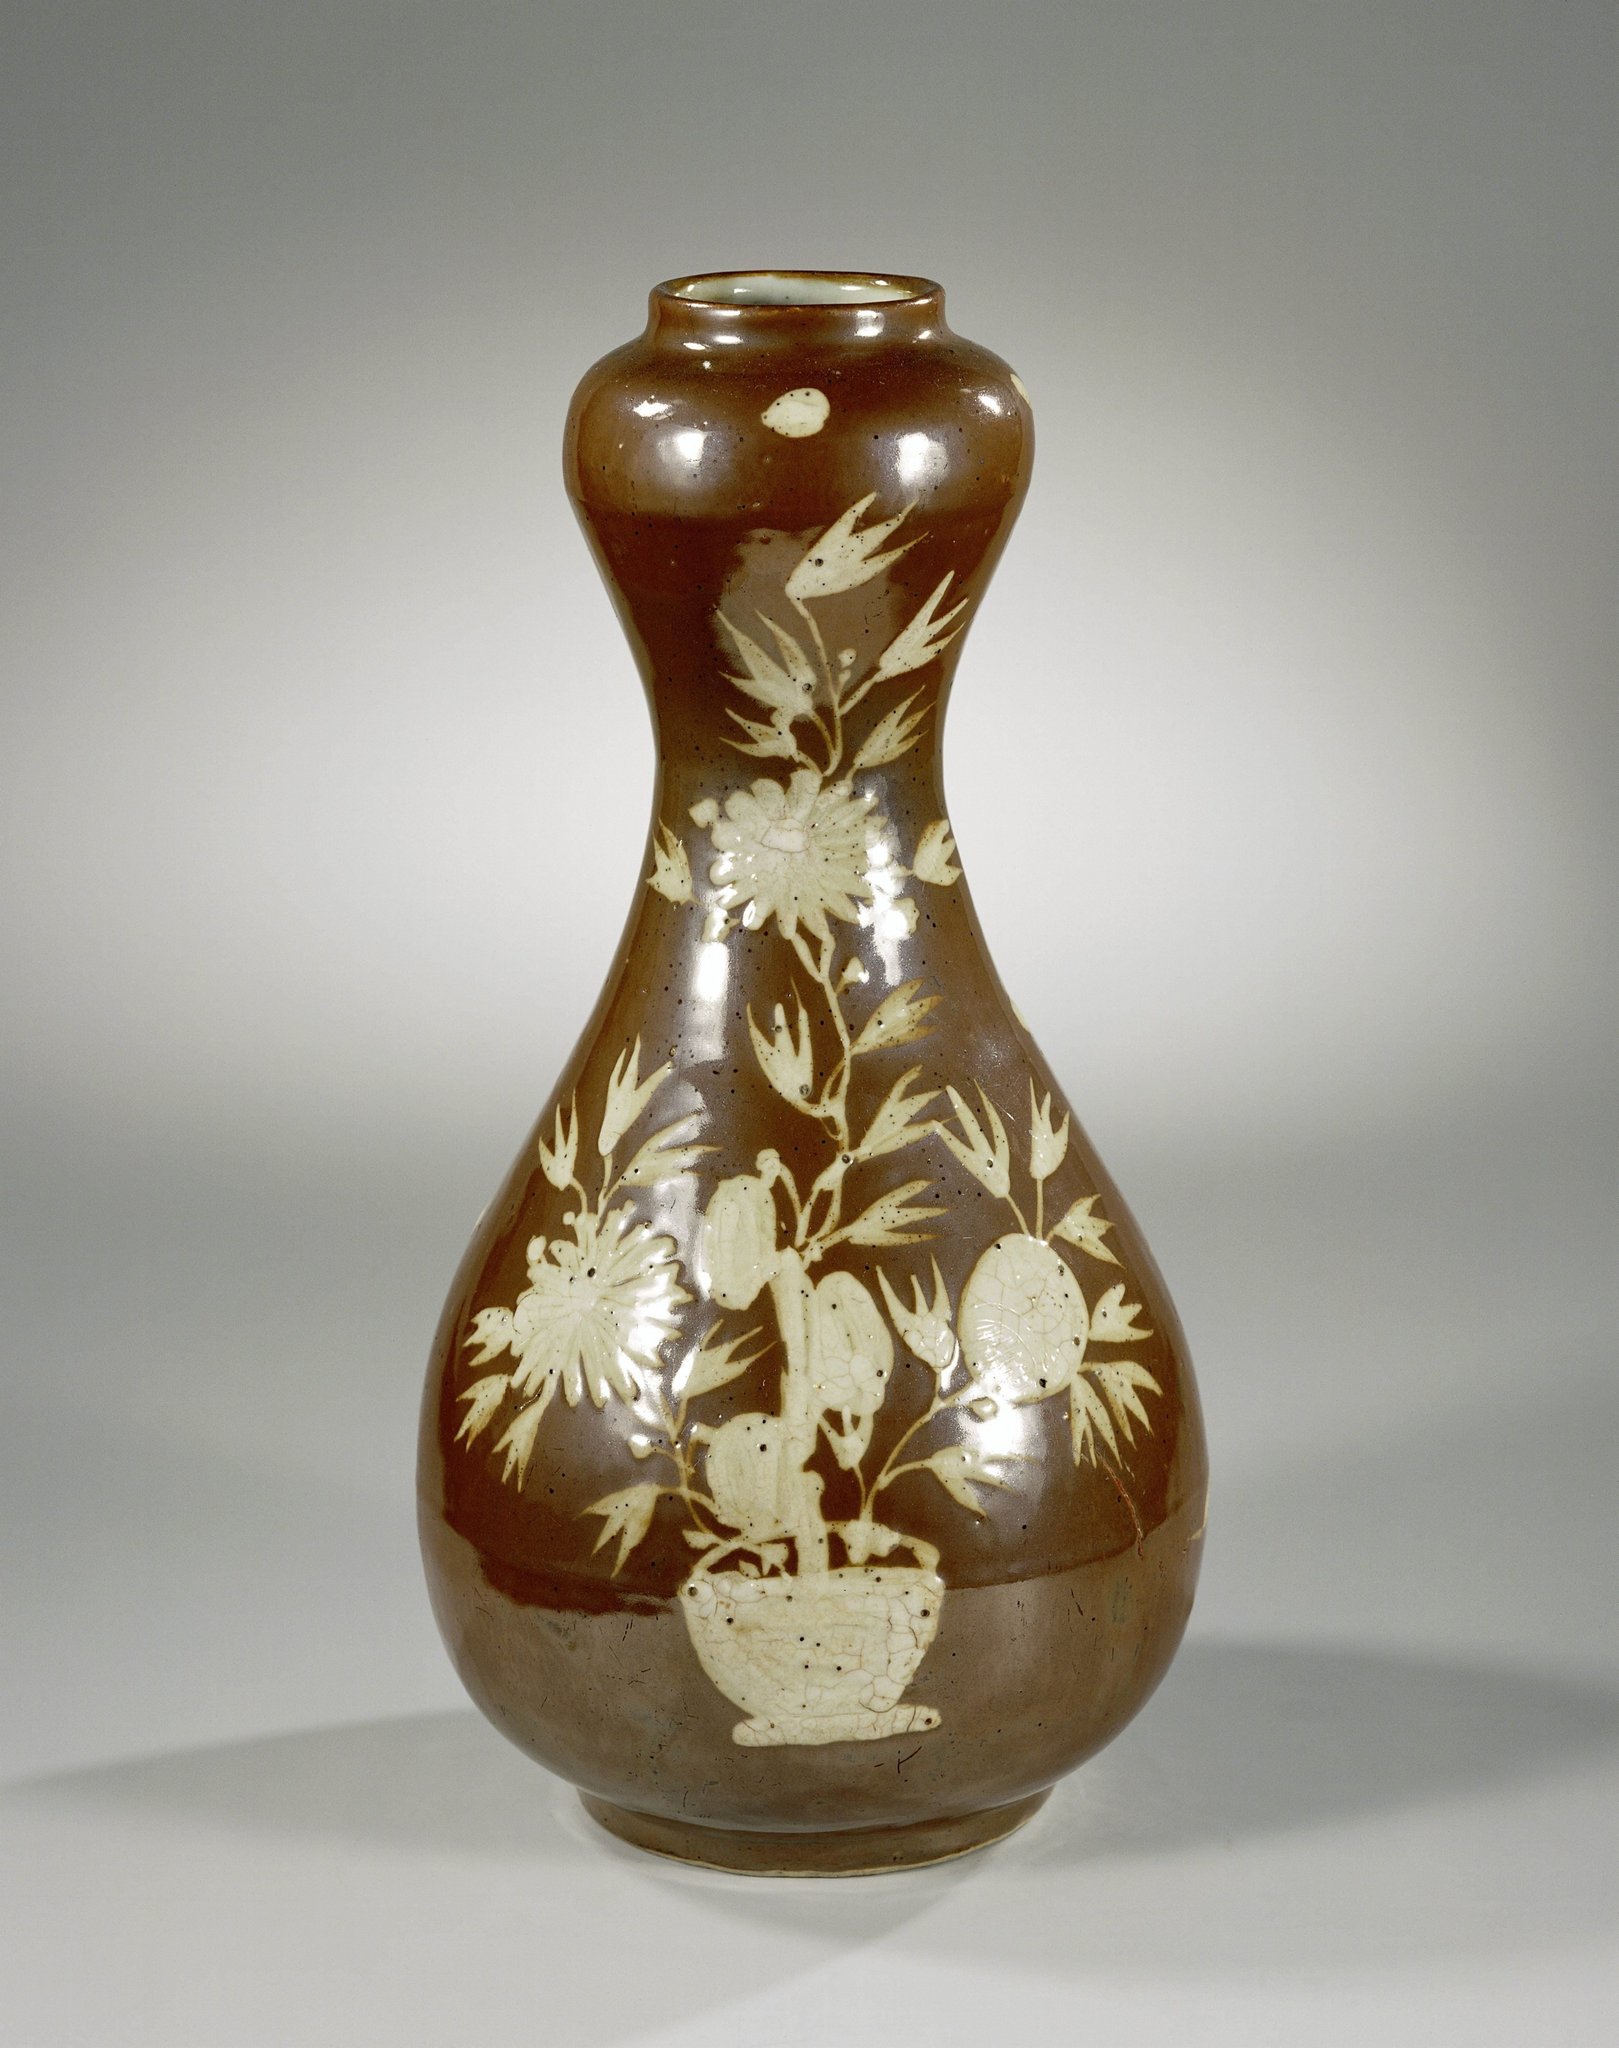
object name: vase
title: Vase with Floral Decoration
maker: Anonymous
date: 1575-1599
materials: glaze, paint, porcelain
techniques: firing, turning, vitrification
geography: china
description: This porcelain vessel is covered with a uniform brown glaze. The white slip floral decoration was applied directly after the glaze had been fired at a high temperature. Made of light, thin porcelain with an even glaze, this vase was probably produced in the Jingdezhen kilns.